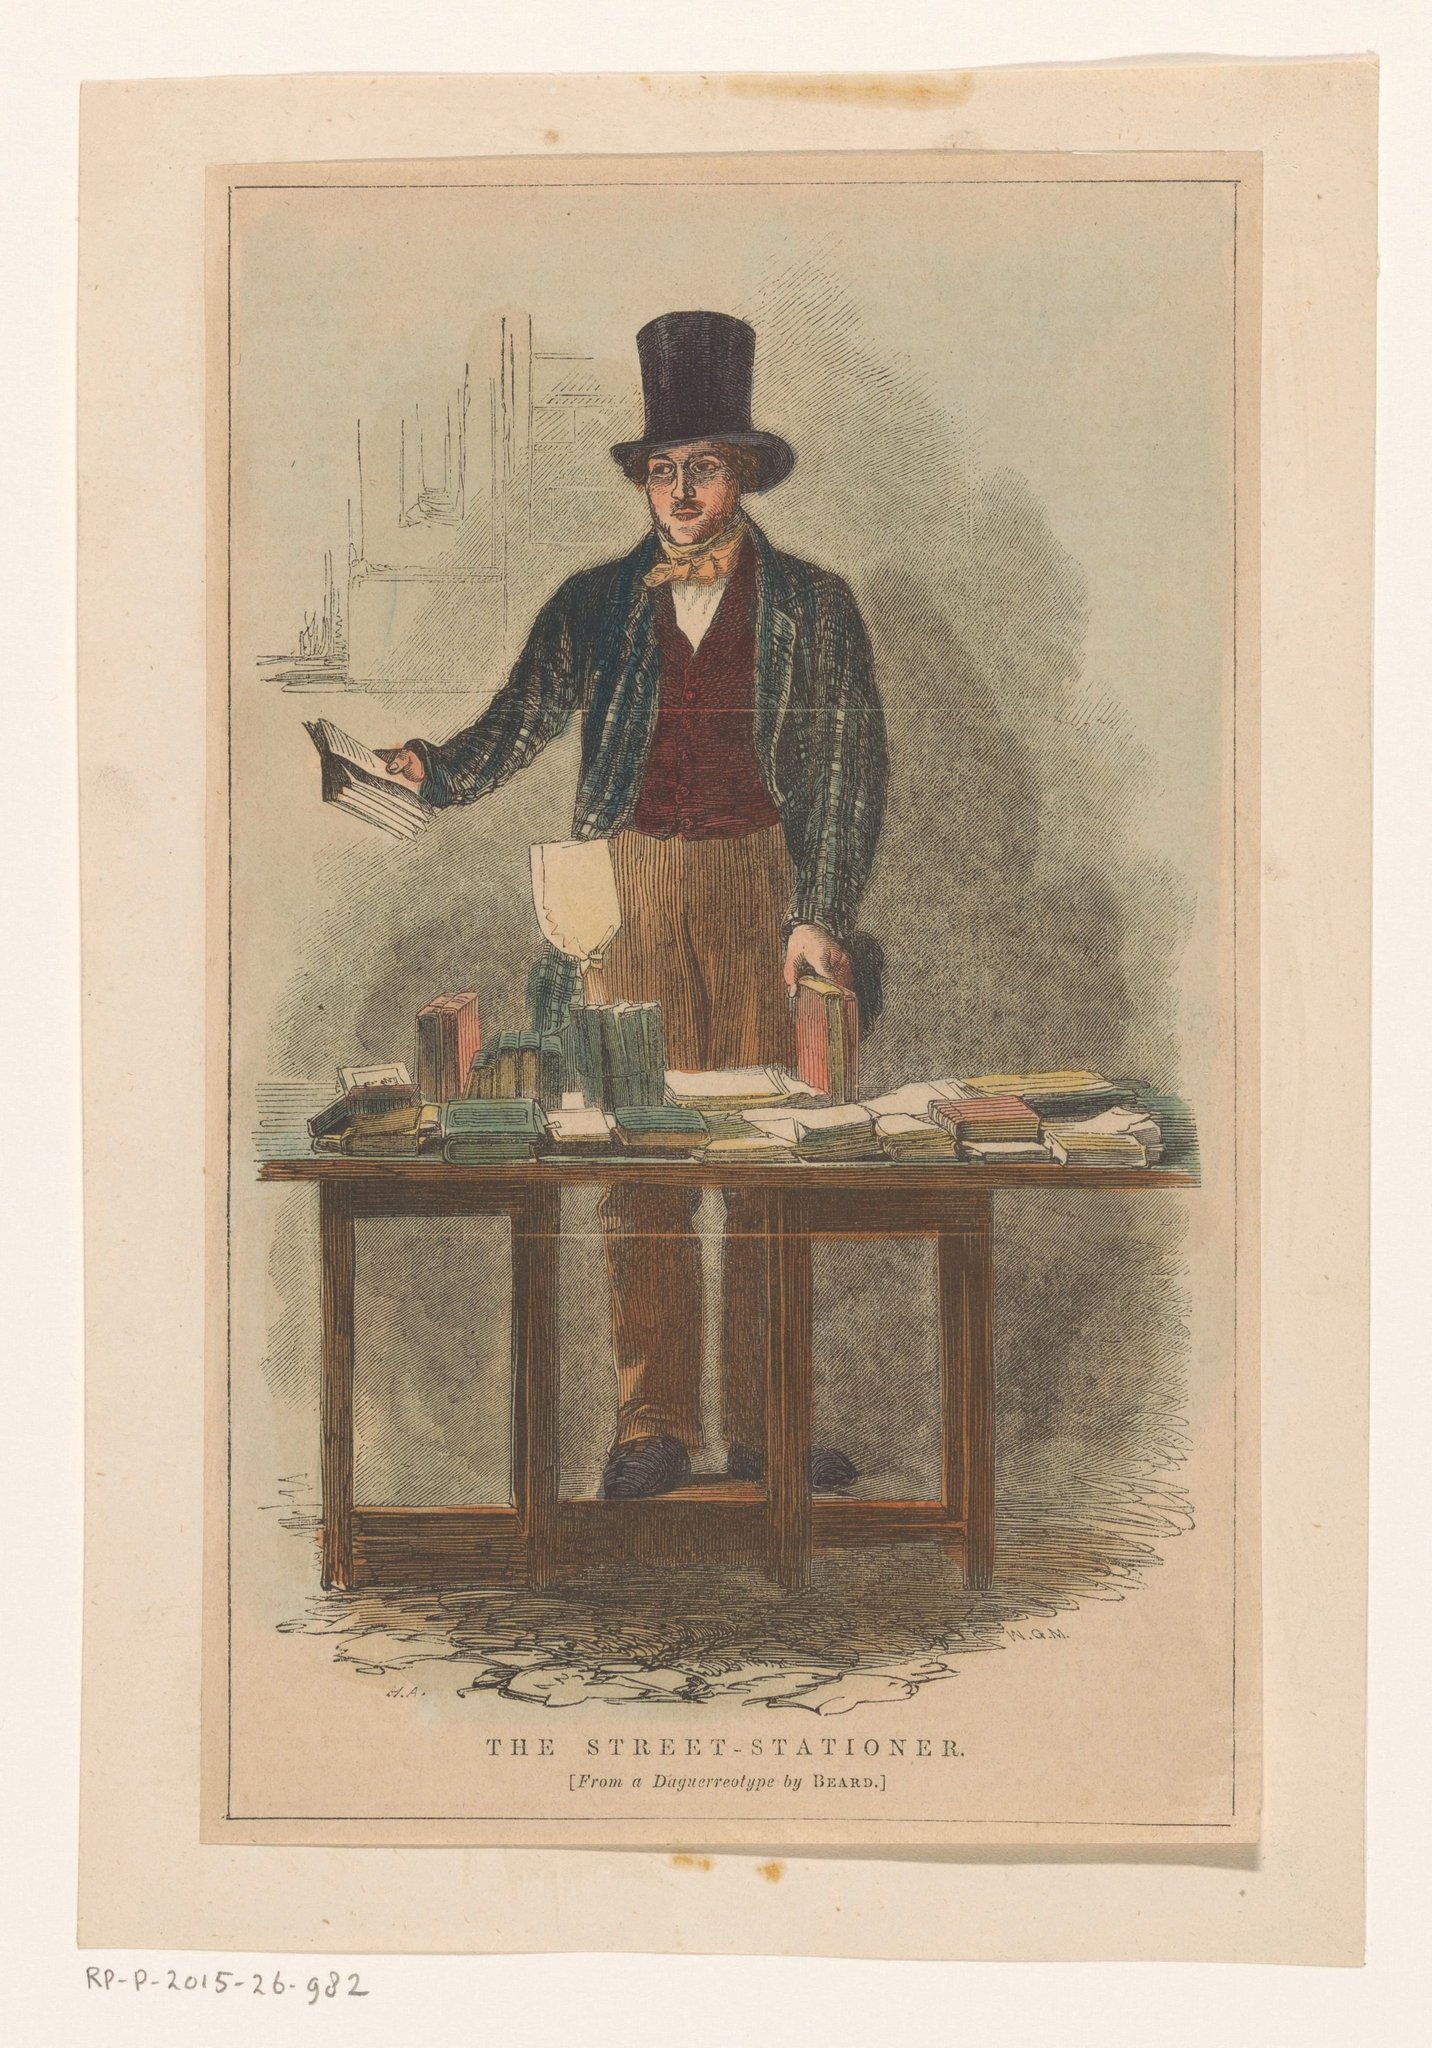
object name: print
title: The street-stationer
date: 1851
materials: paper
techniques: hand coloring, engraving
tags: street-trader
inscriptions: collector's mark: Lugt 2228, collector's mark: Lugt 4779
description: Prent afkomstig uit deel 1 van: Mayhew, Henry. London Labour and the London Poor. 4 dln. Londen: 1851-1862.